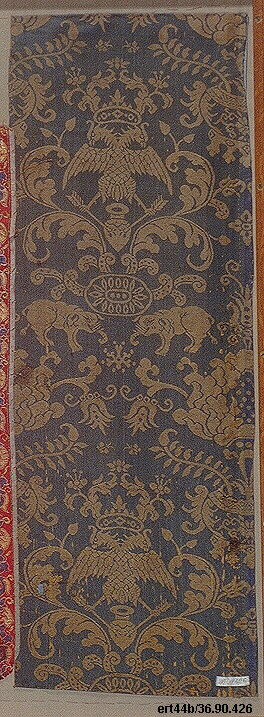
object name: piece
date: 1501-1600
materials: silk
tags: eagles,elephants